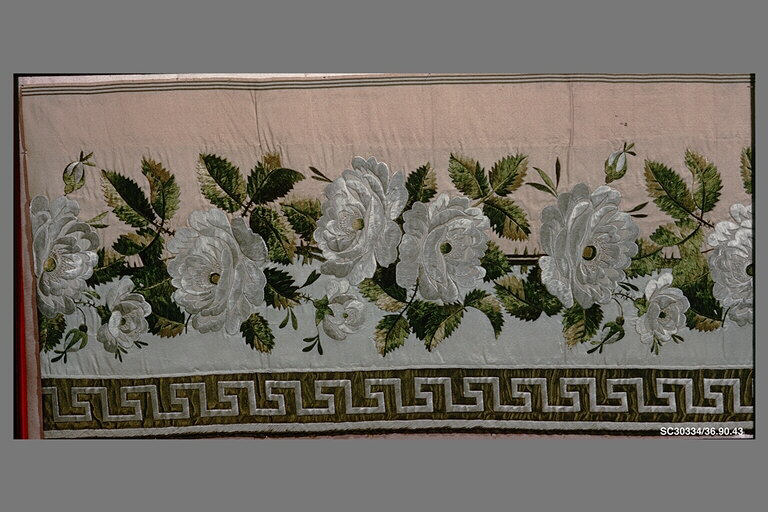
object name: border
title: Dress border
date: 1801-1833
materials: silk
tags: roses